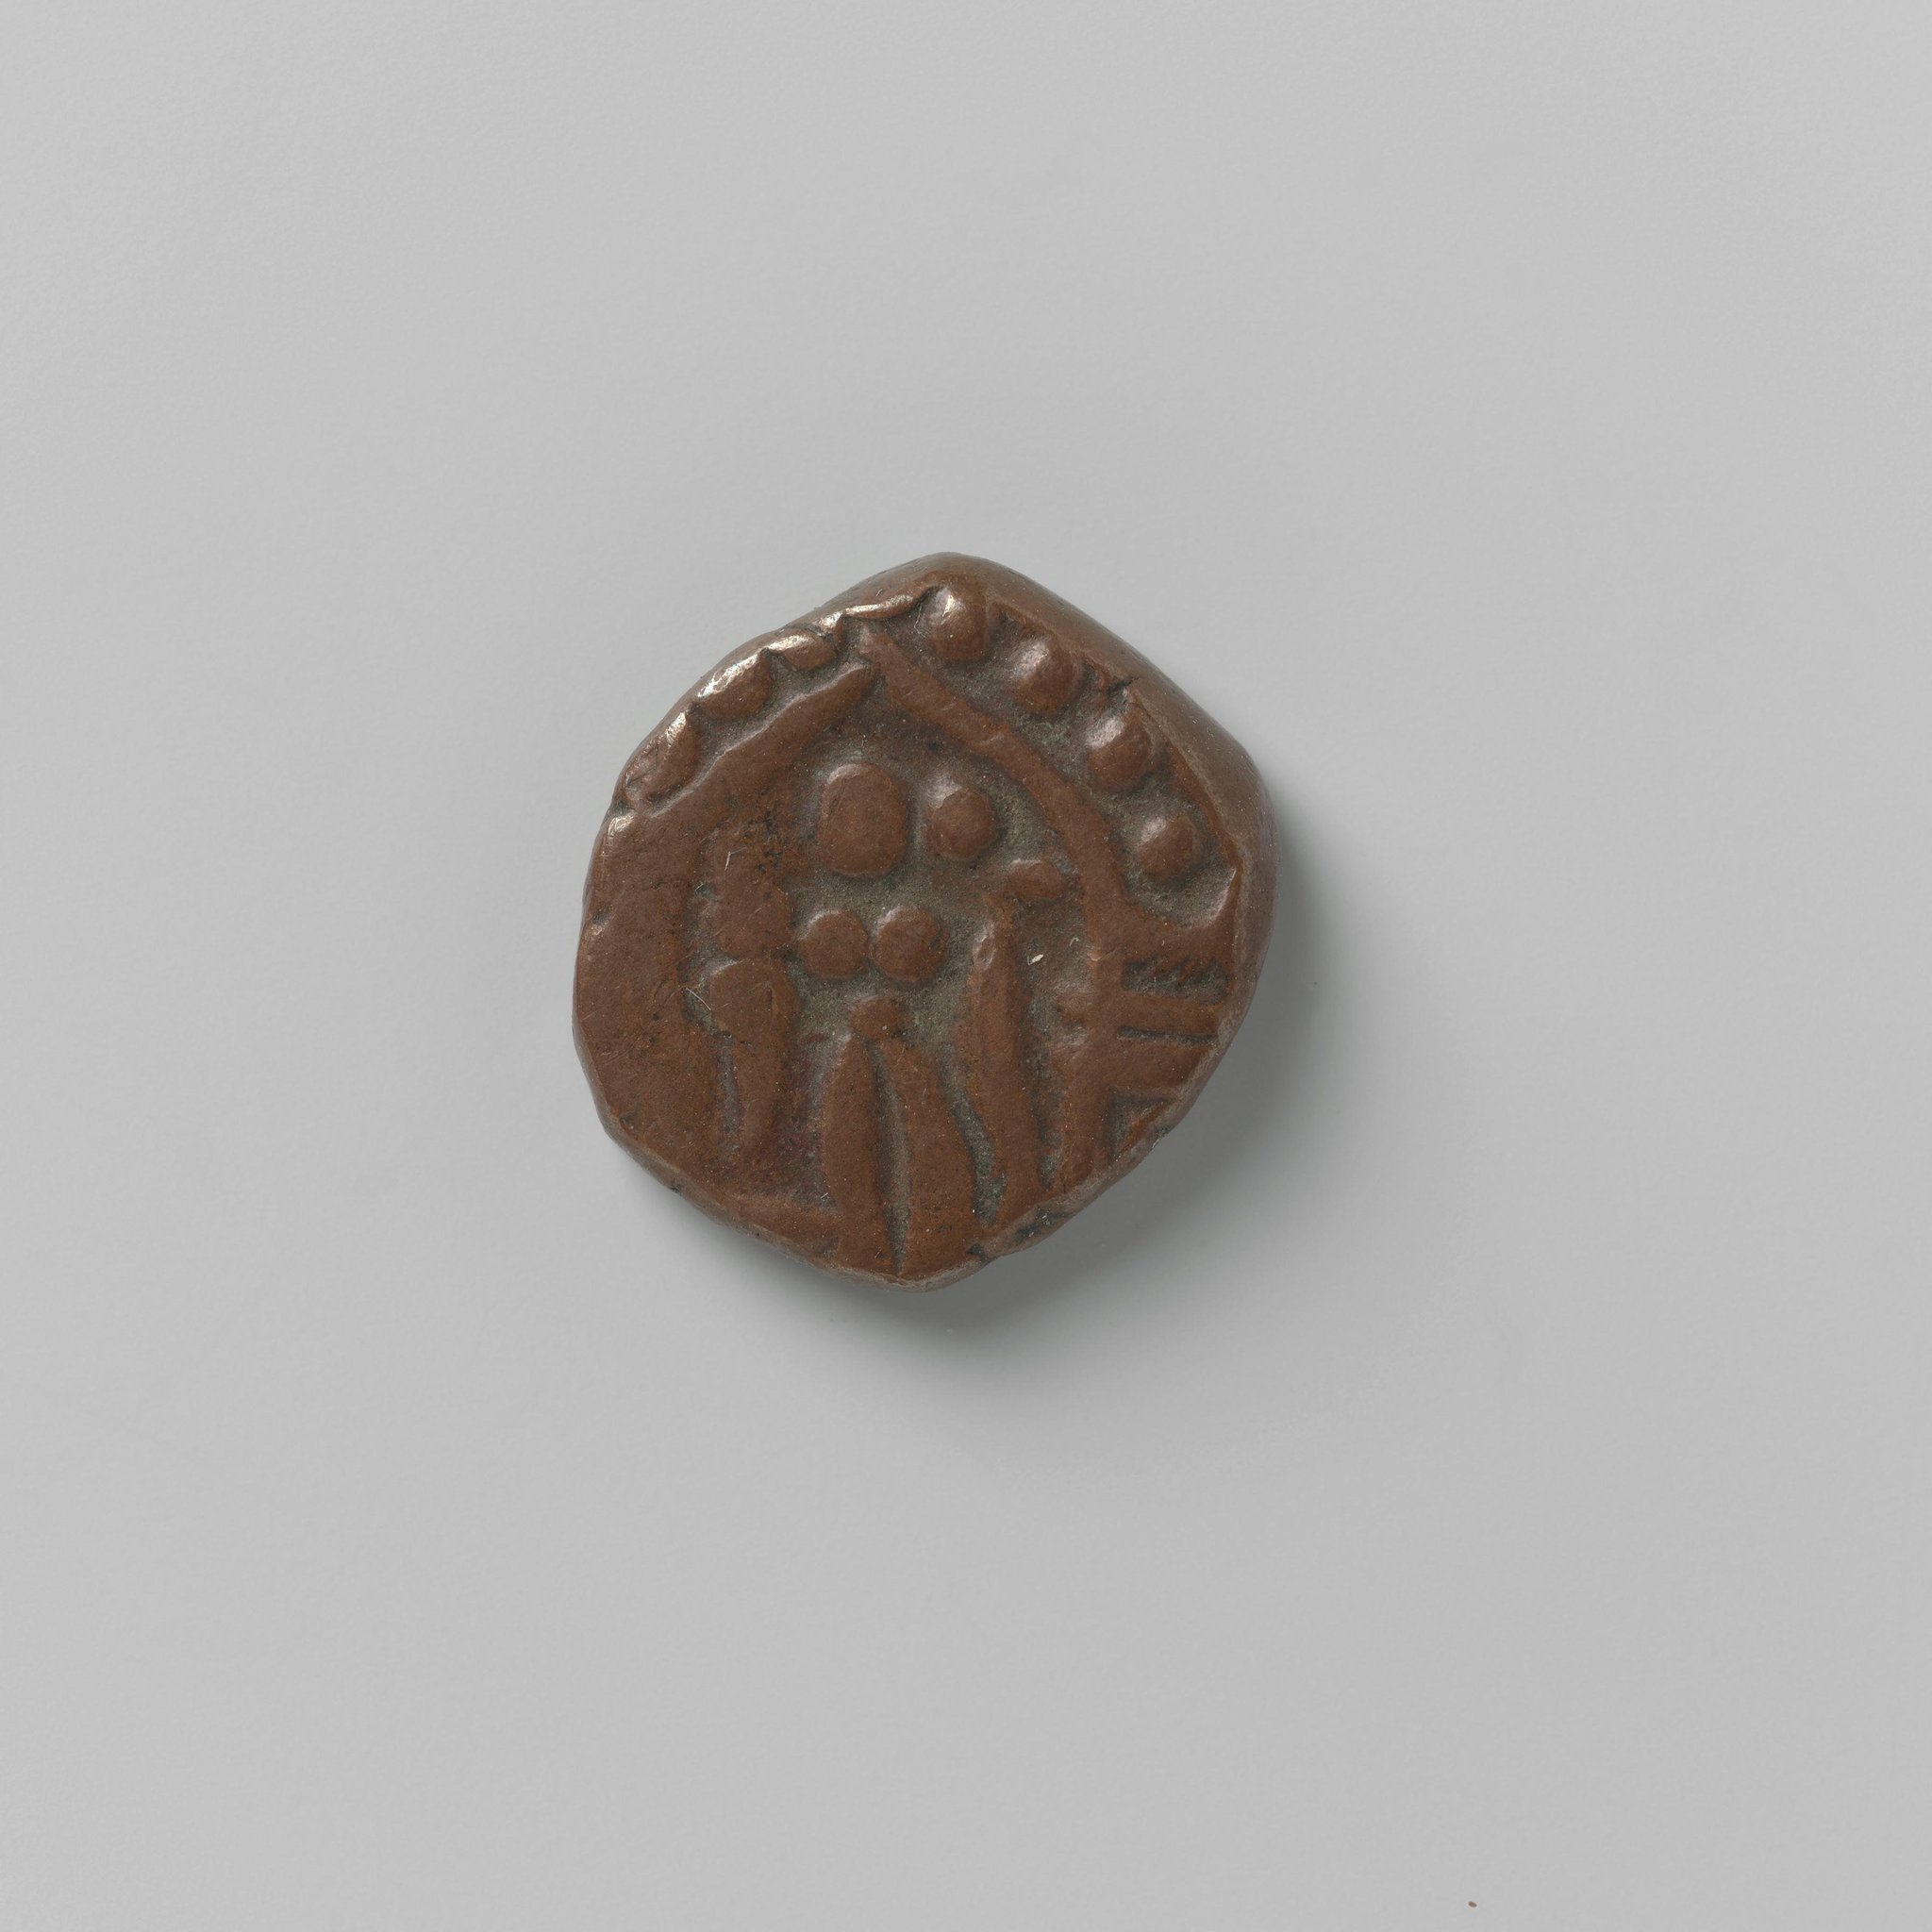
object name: coin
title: Kas uit Madura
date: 1700-1800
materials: copper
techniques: striking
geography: madura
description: Voorzijde: onbekende figuratie. Keerzijde: tweeregelig opschrift in Arabische lettertekens.